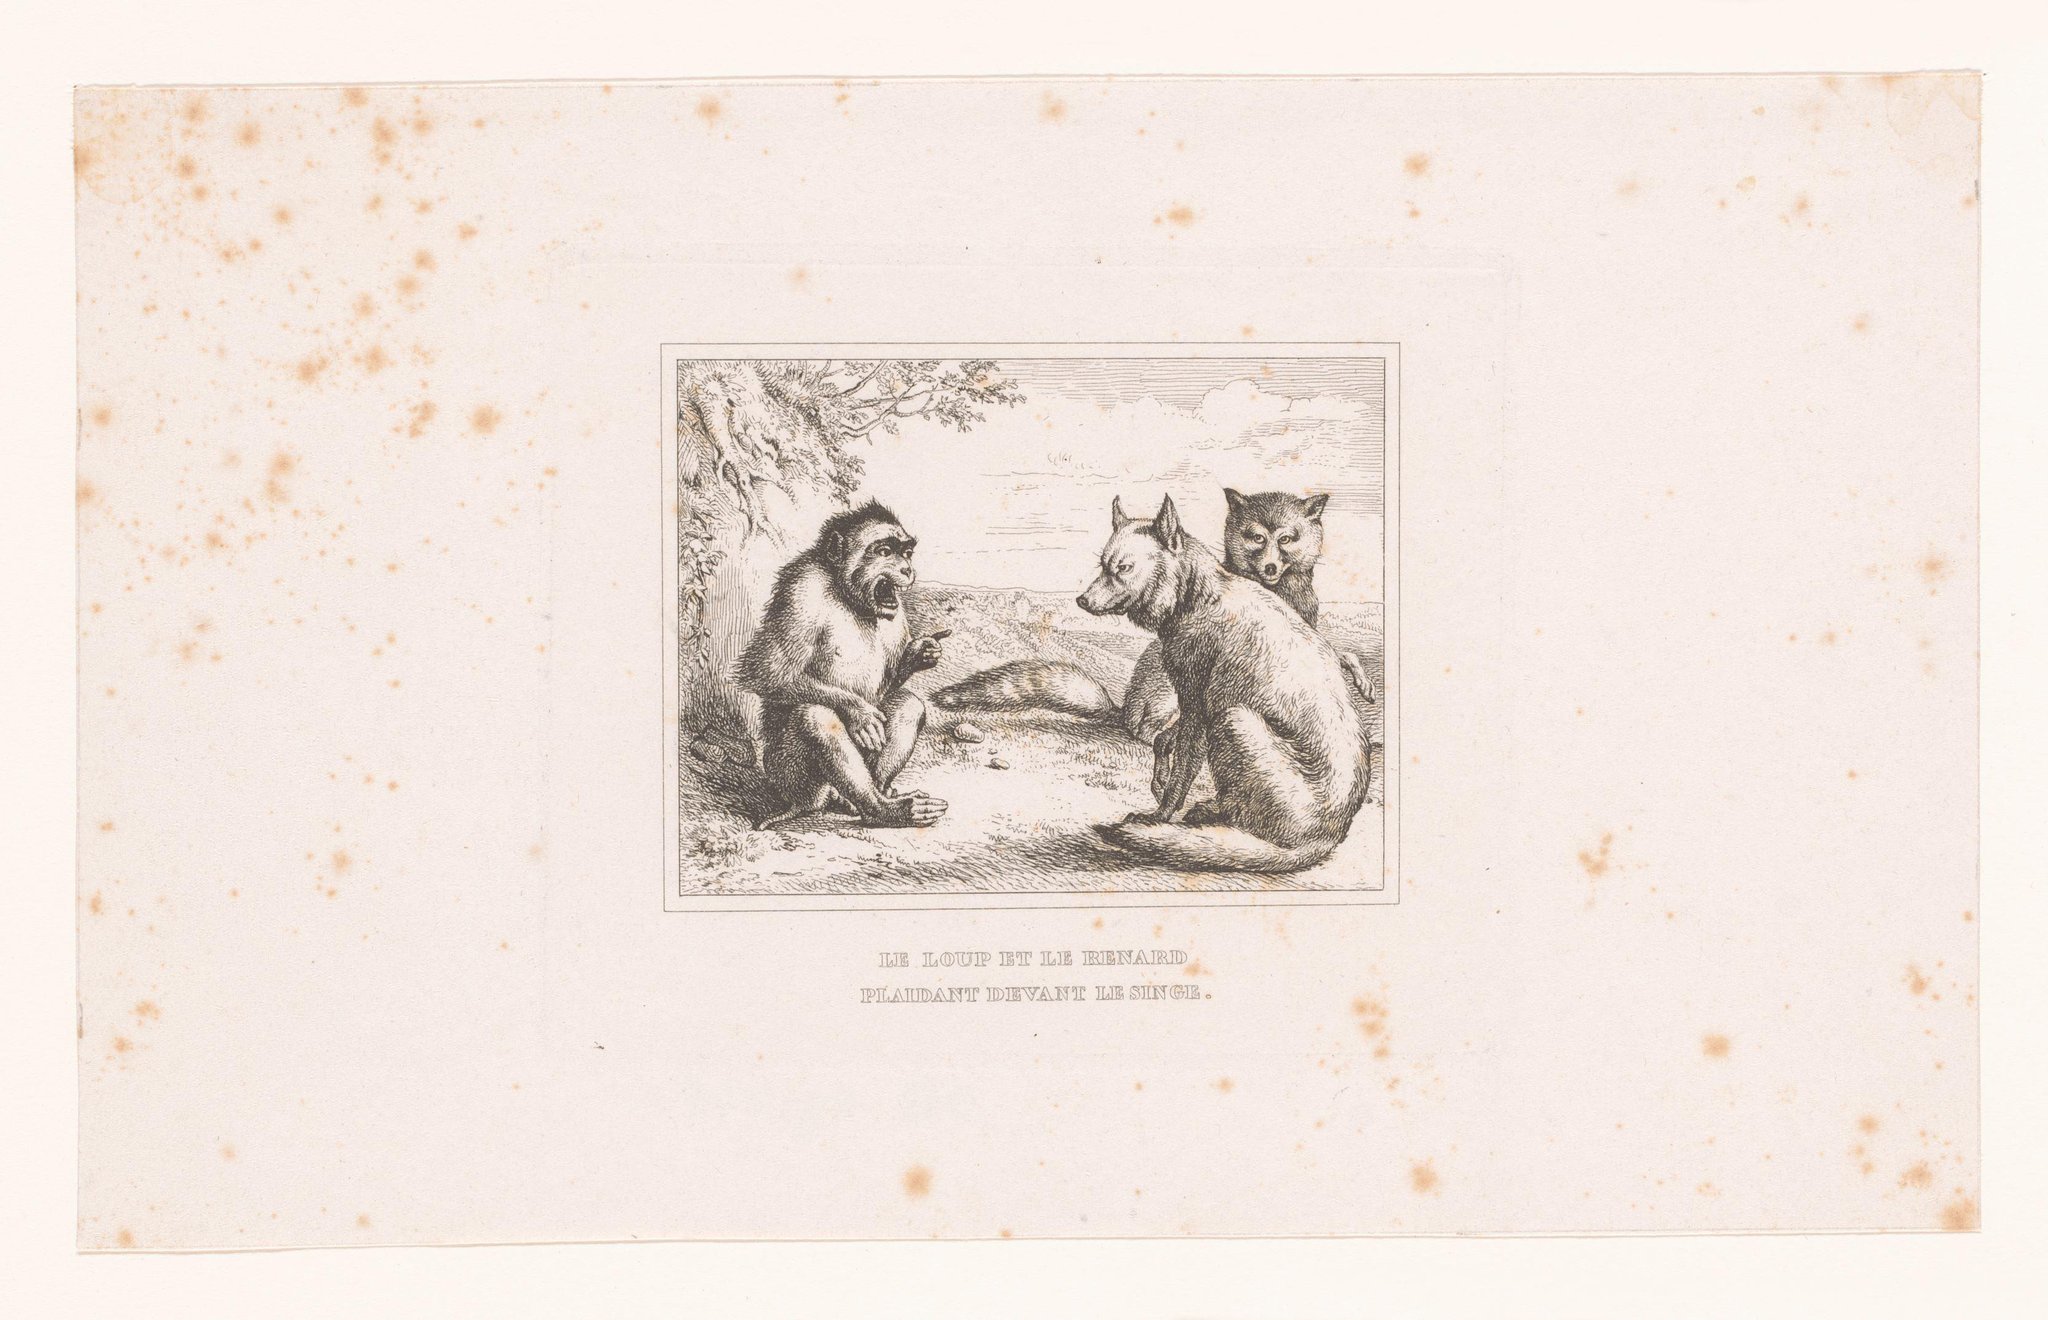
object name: print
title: Fabels van La Fontaine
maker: eugène verboeckhoven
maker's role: draughtsman, painter, print maker, printer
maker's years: 1798-1881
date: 1808-1881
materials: paper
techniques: etching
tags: monkeys, apes, fables, beasts of prey, predatory animals: fox, beasts of prey, predatory animals: wolf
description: Prent maakt deel uit van een serie van acht prenten met scènes uit de fabels van Jean de La Fontaine.